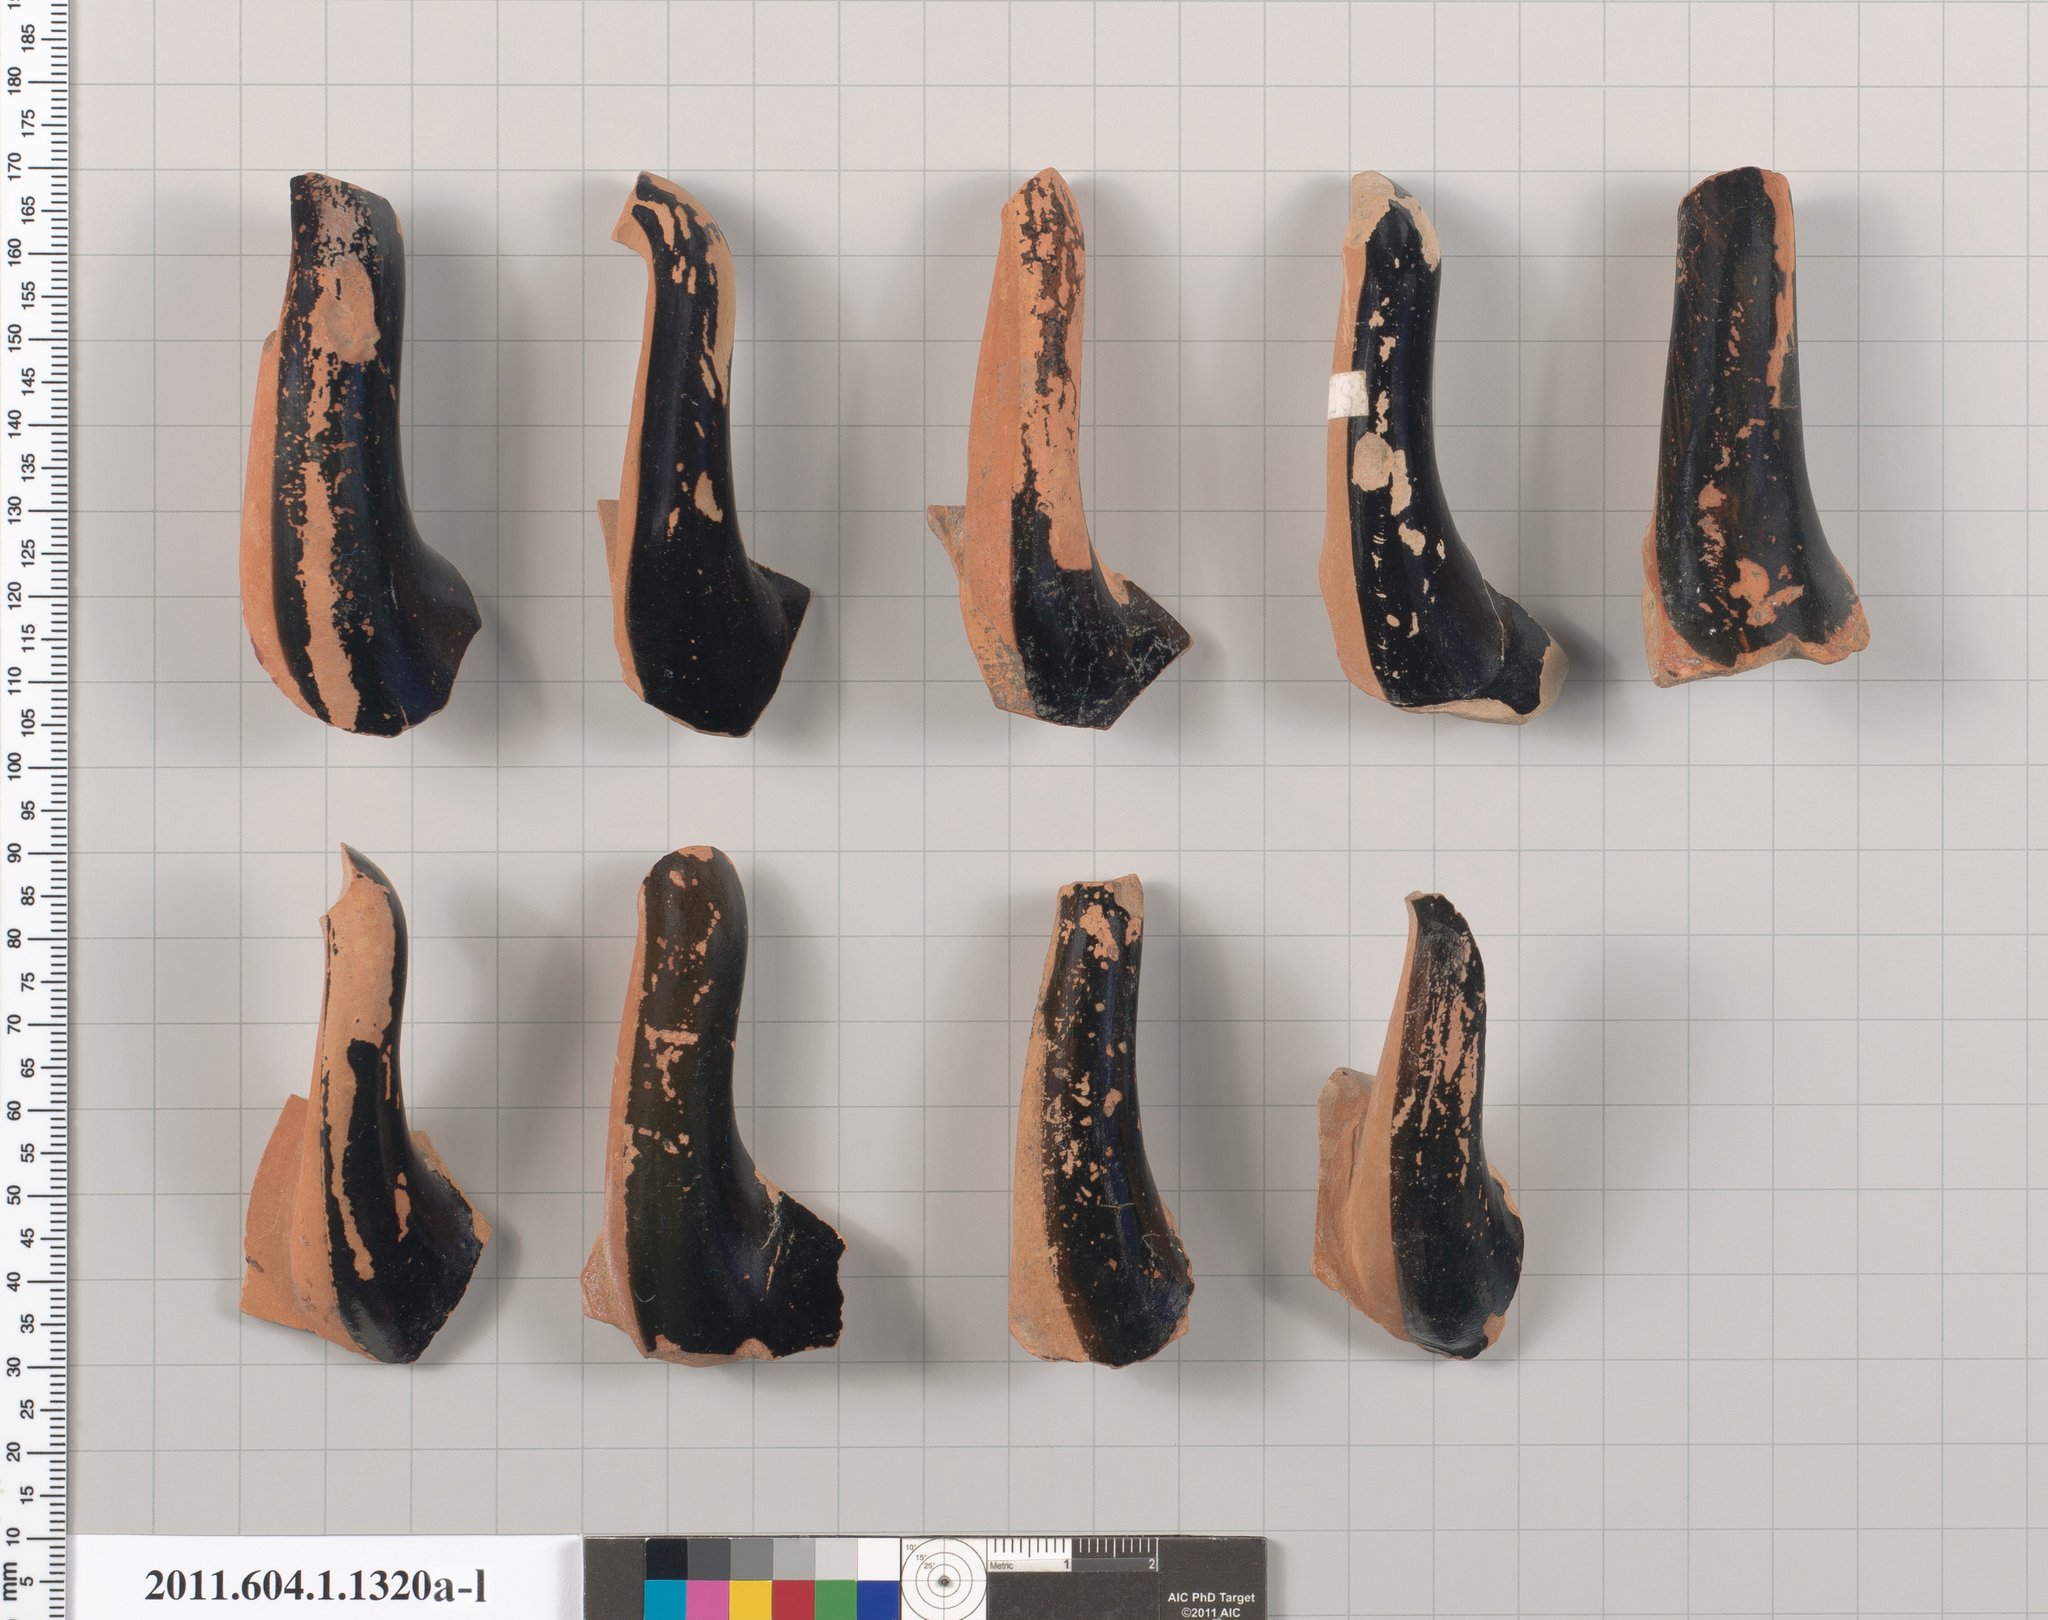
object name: kylix fragment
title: Terracotta fragments of kylikes (drinking cups)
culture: greek, attic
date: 500-401 BCE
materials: terracotta